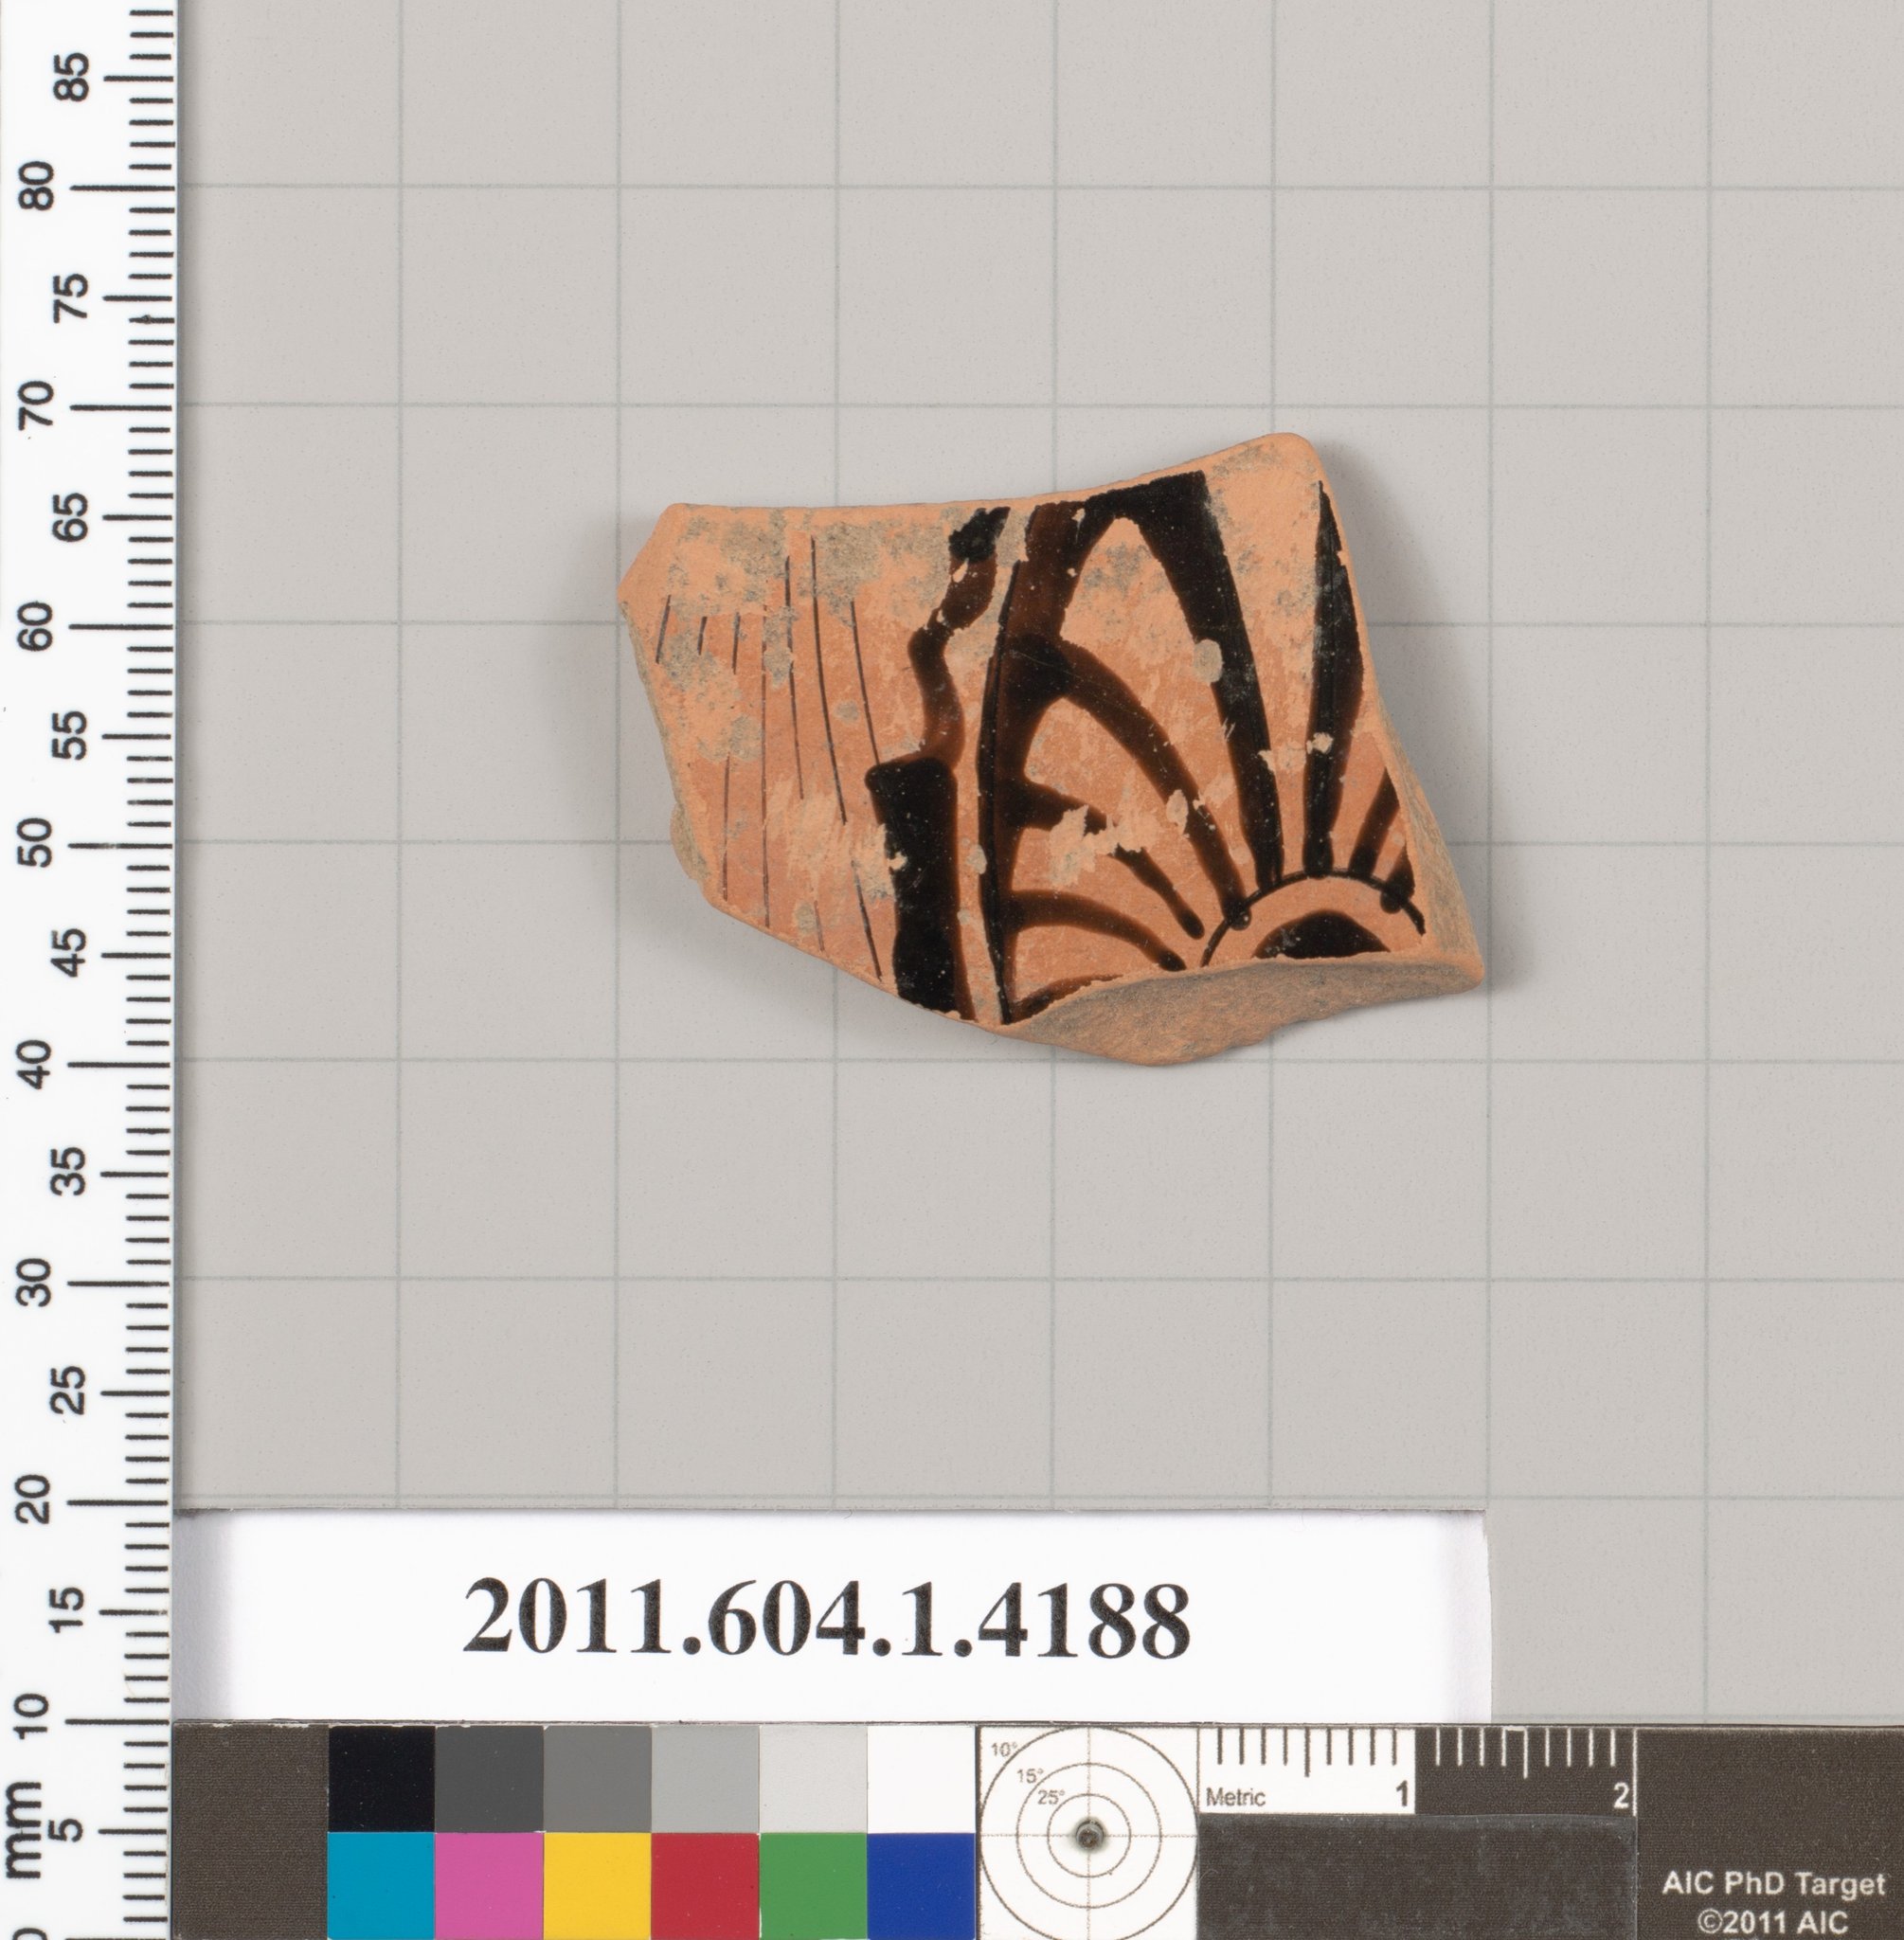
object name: kylix fragment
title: Terracotta fragment of a kylix (drinking cup)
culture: greek, attic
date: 475-451 BCE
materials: terracotta